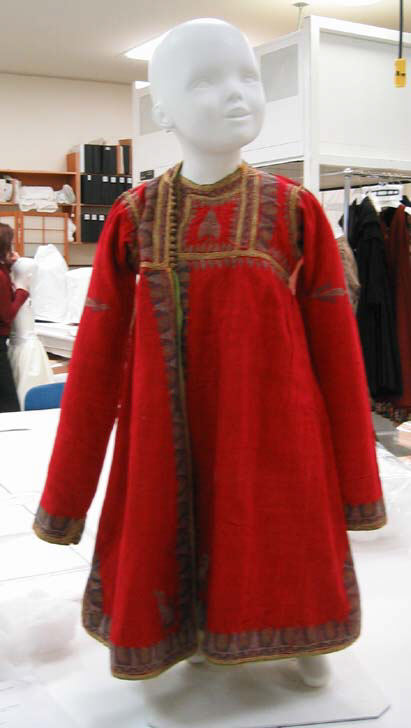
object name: coat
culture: indian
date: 1849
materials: metal, silk, wool